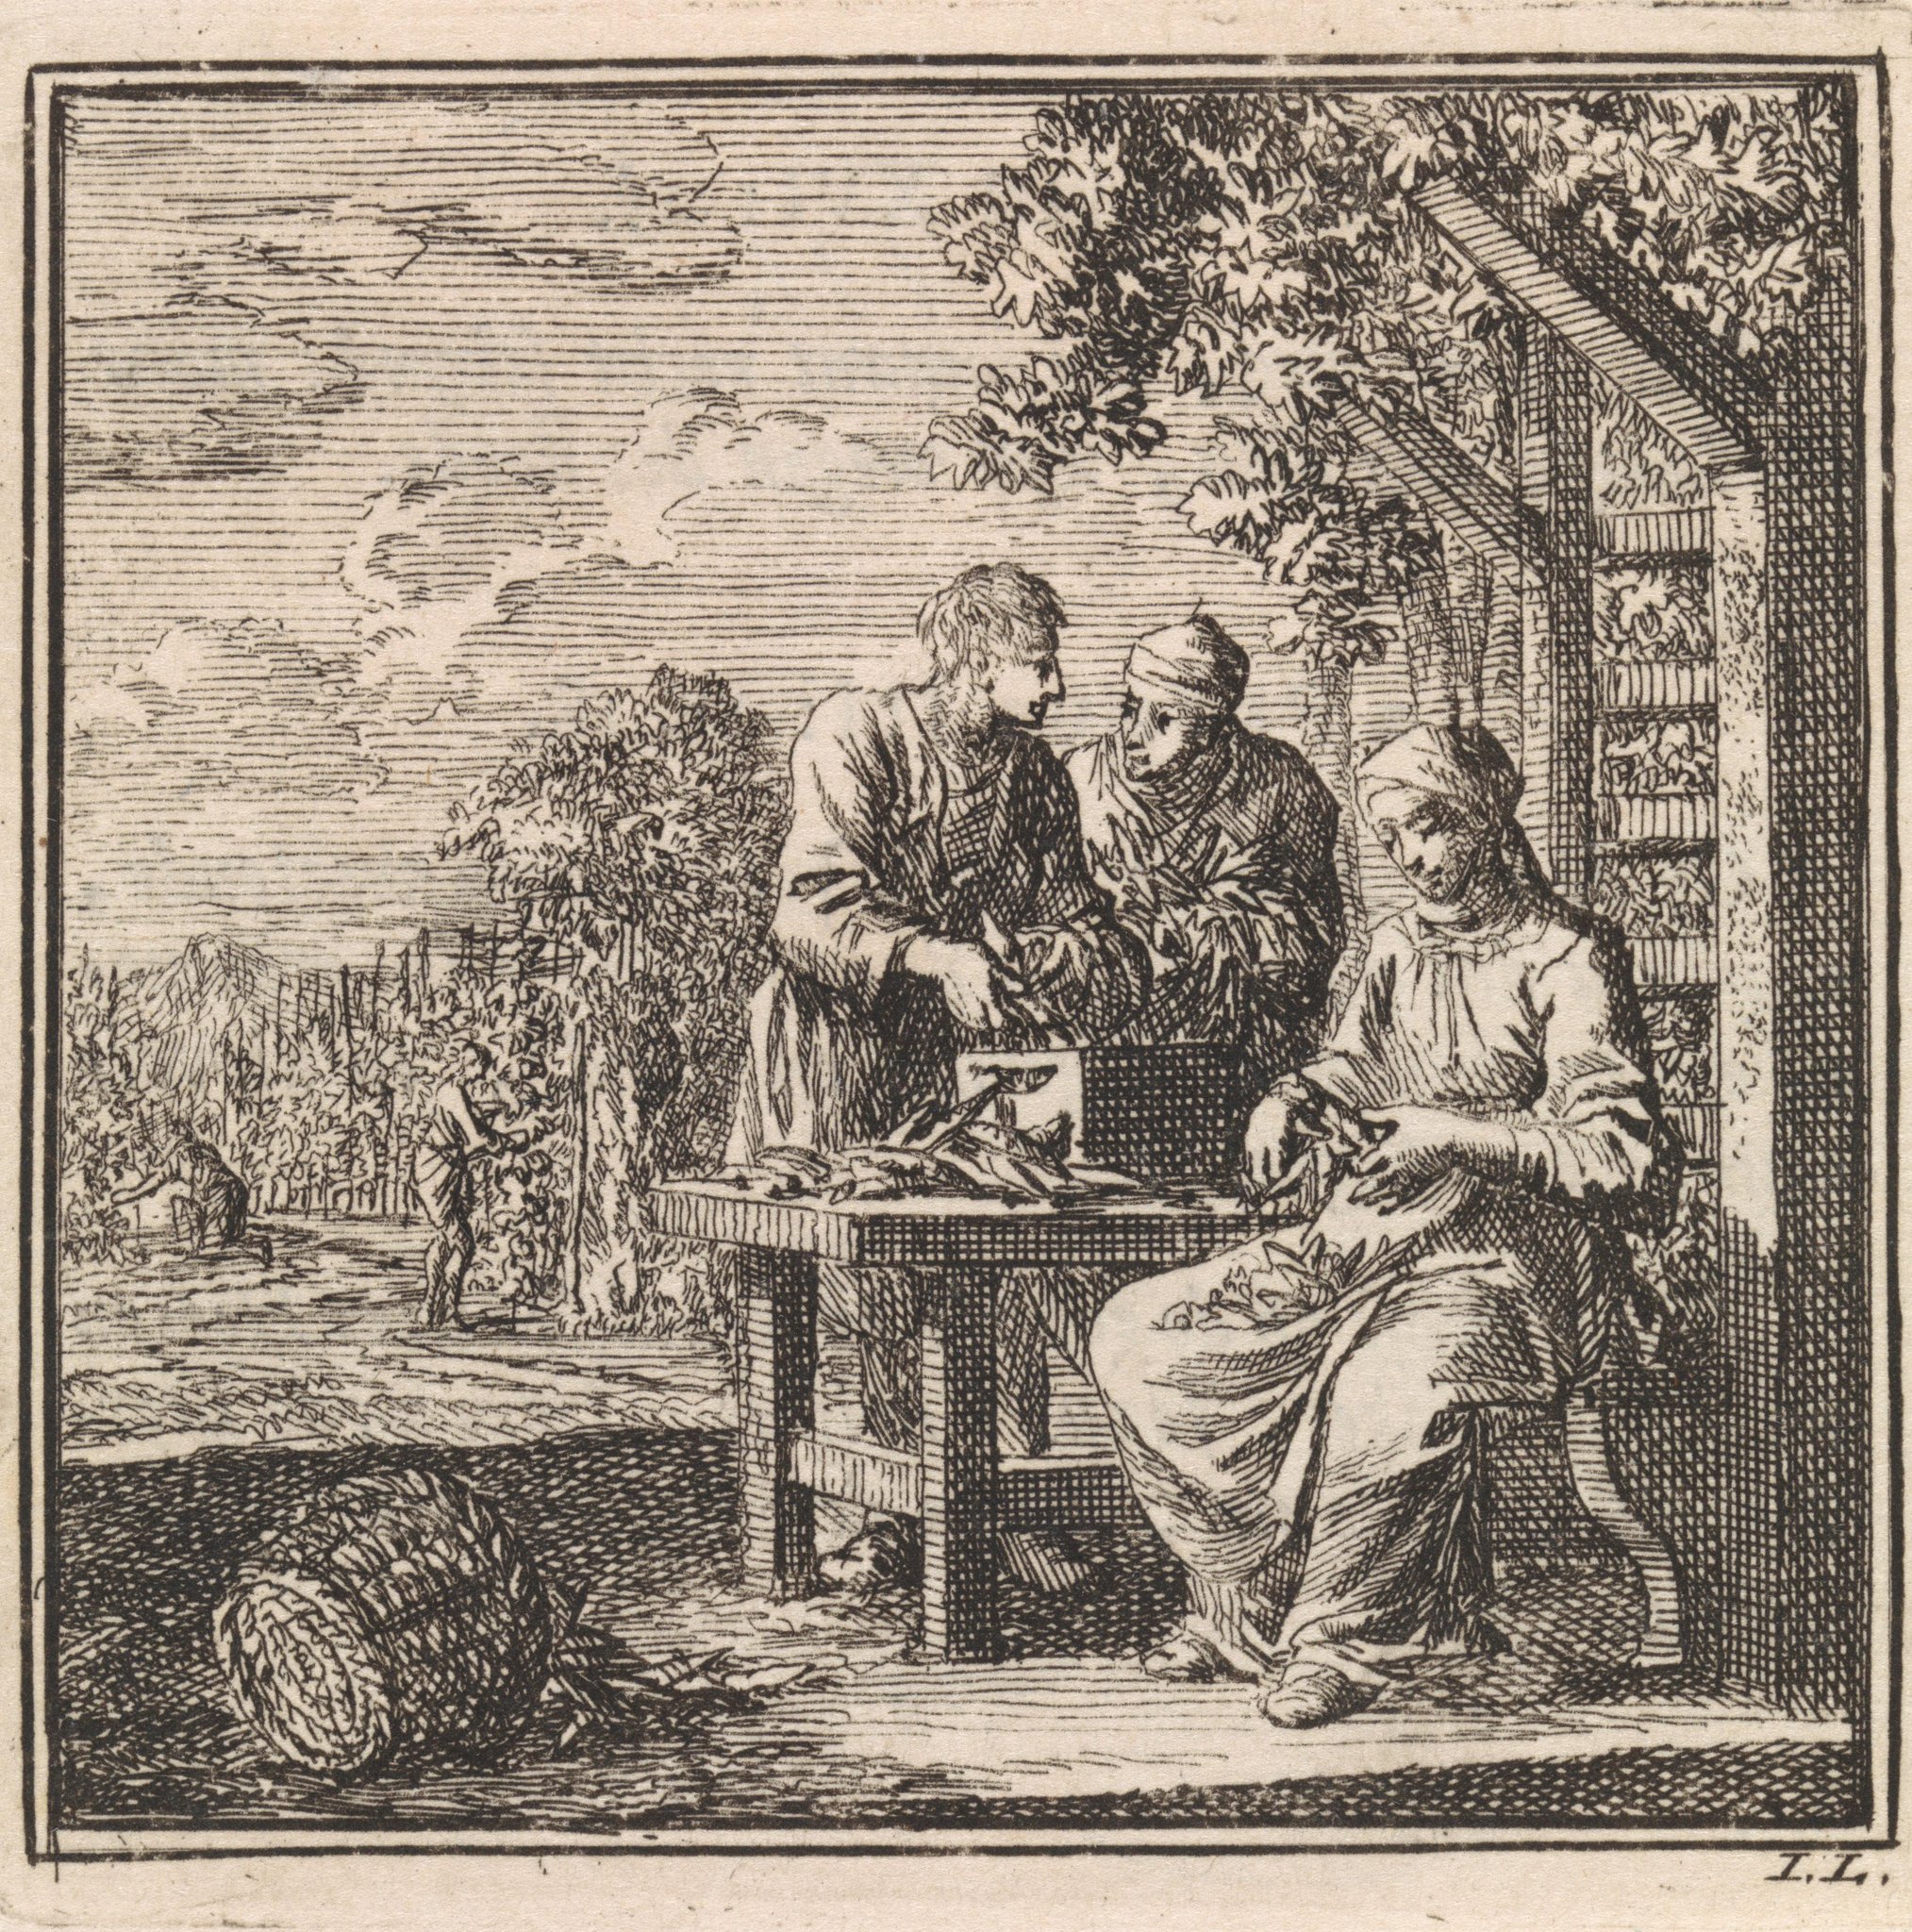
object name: book illustration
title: Bij een prieel doppen drie figuren erwten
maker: jan luyken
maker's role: draughtsman, print maker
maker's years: 1649-1712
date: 1711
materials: paper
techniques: etching, letterpress printing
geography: amsterdam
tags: garden, summer-house, arbour, garden-house (dutch: 'theekoepel'), plants and herbs: pea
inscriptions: collector's mark: Lugt 2228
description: Titelpagina voor: Luyken, Jan. De Bykorf des Gemoeds. Amsterdam: Pieter Arentsz. II (wed.) en Cornelis van der Sys, 1711, p. 114.